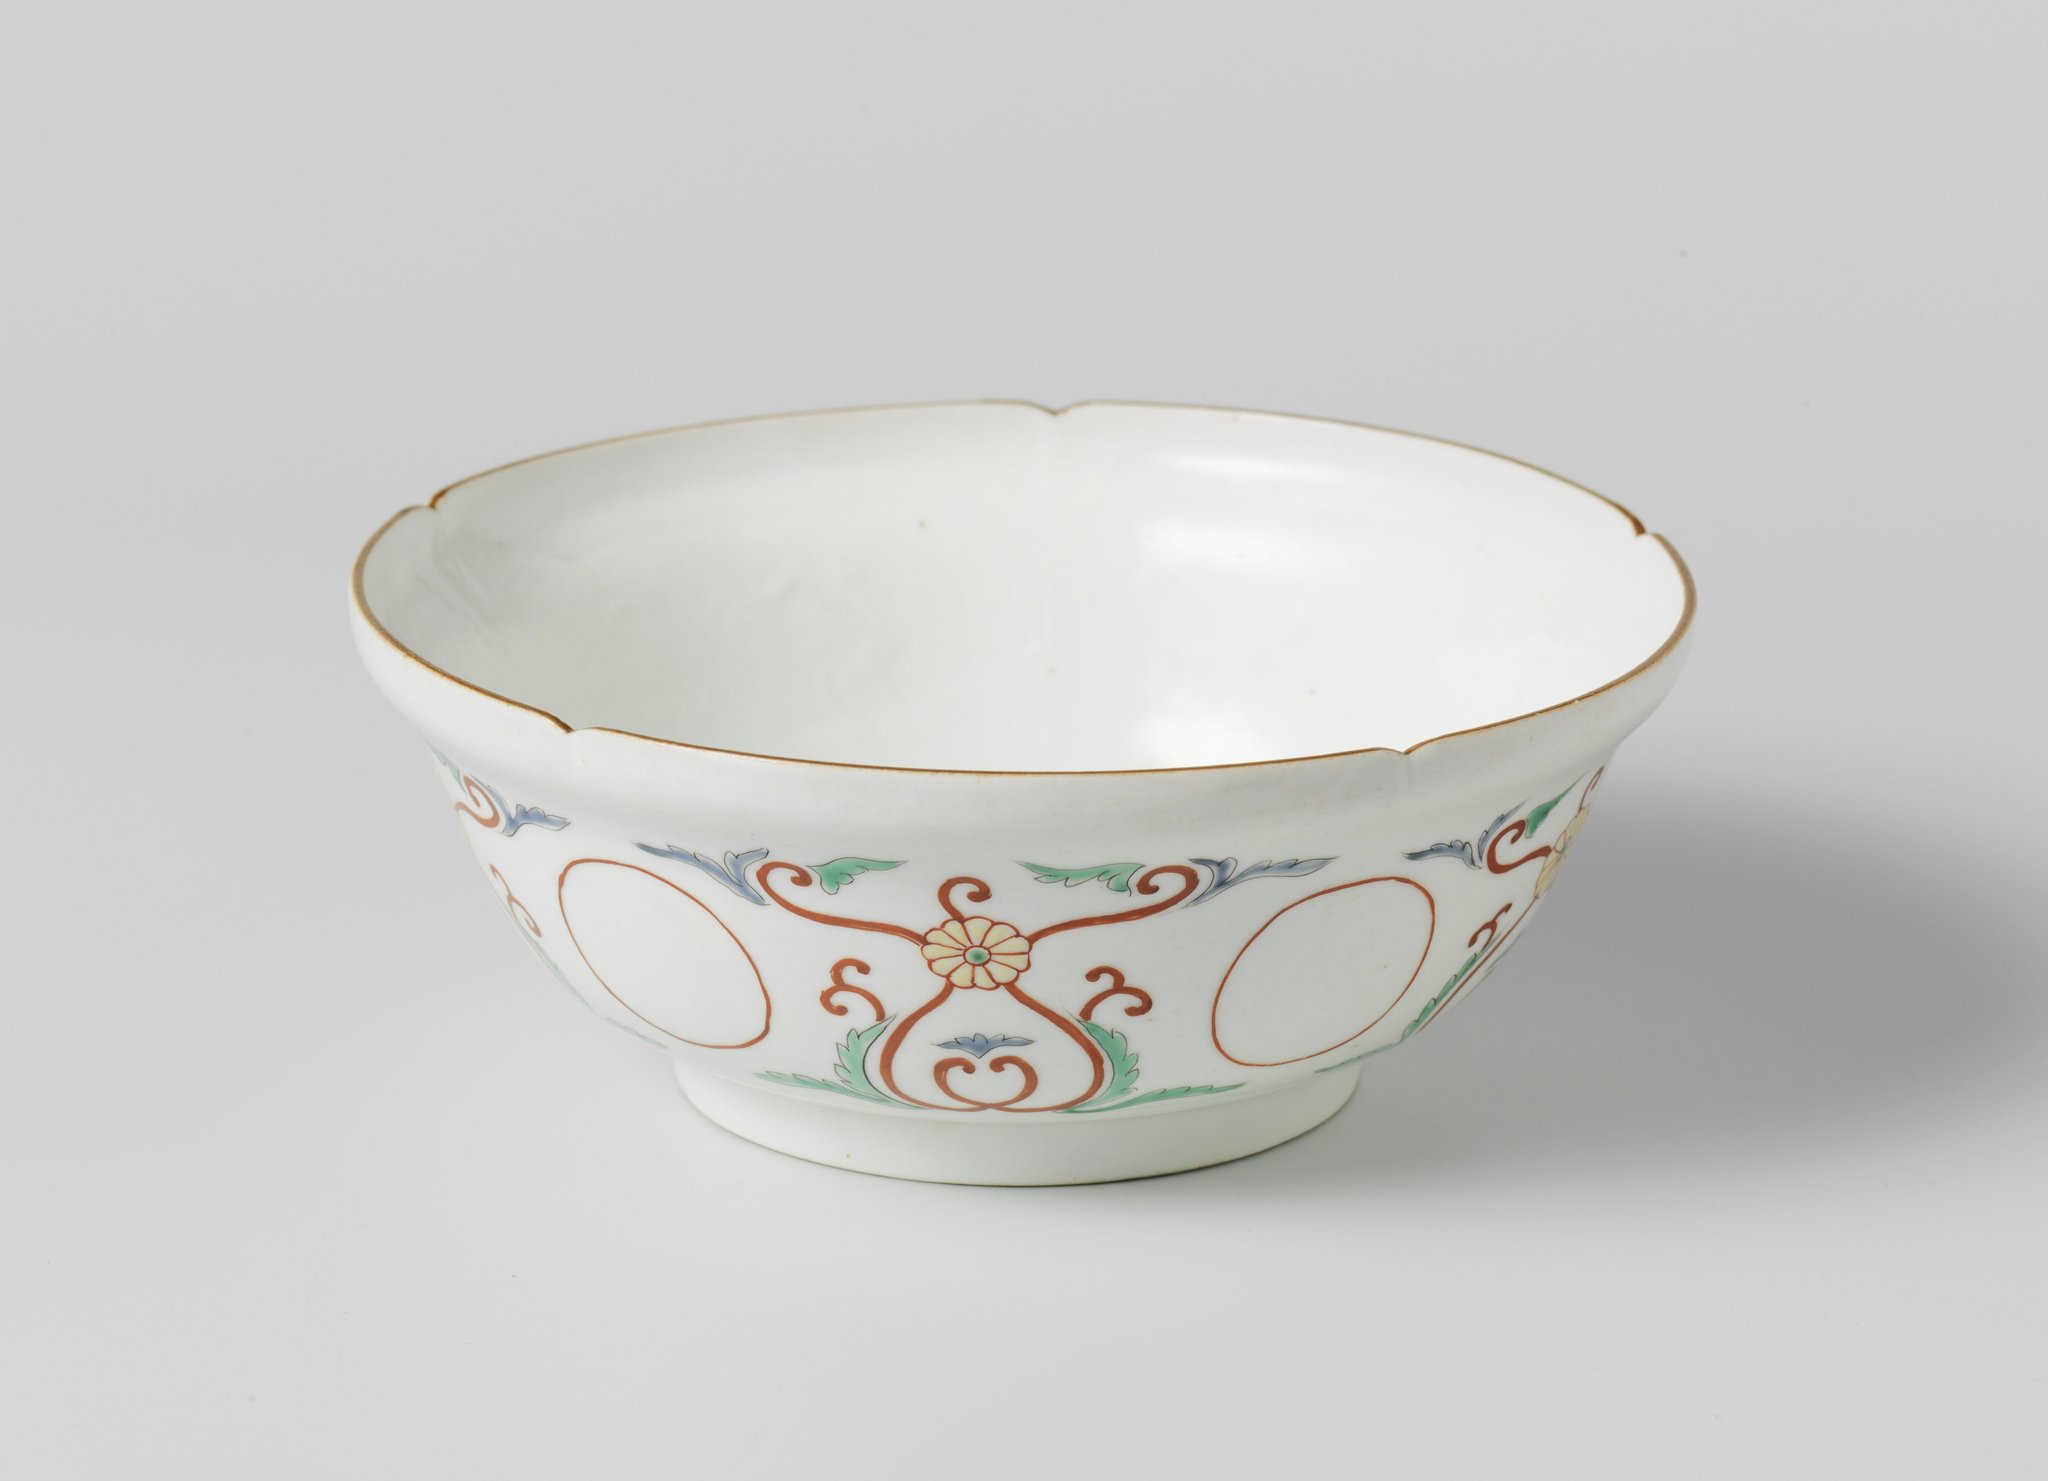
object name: bowl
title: Bowl with trees in reliëf, deer and floral scrolls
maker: Anonymous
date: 1700-1799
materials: glaze, paint, porcelain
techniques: firing, relief, turning, vitrification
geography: japan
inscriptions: label: ‘Collectie Westendorp/ 119’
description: Kom van porselein met vrijfmaal gelobde rand, beschilderd op het glazuur in blauw, rood, groen, geel en zwart. Op de binnenwand vijf vakken met bomen (o.a. pijnboom) in licht reliëf. In emailkleuren op de bodem twee herten bij een bak. Op de buitenwand bloemranken en lege medaillons. Emaildecoratie mogelijk later toegevoegd in Japan of Europa. Oud label op de onderzijde met 'Collectie Westendorp/ 119'. Bruine rand. Arita, Kakiemon-stijl.